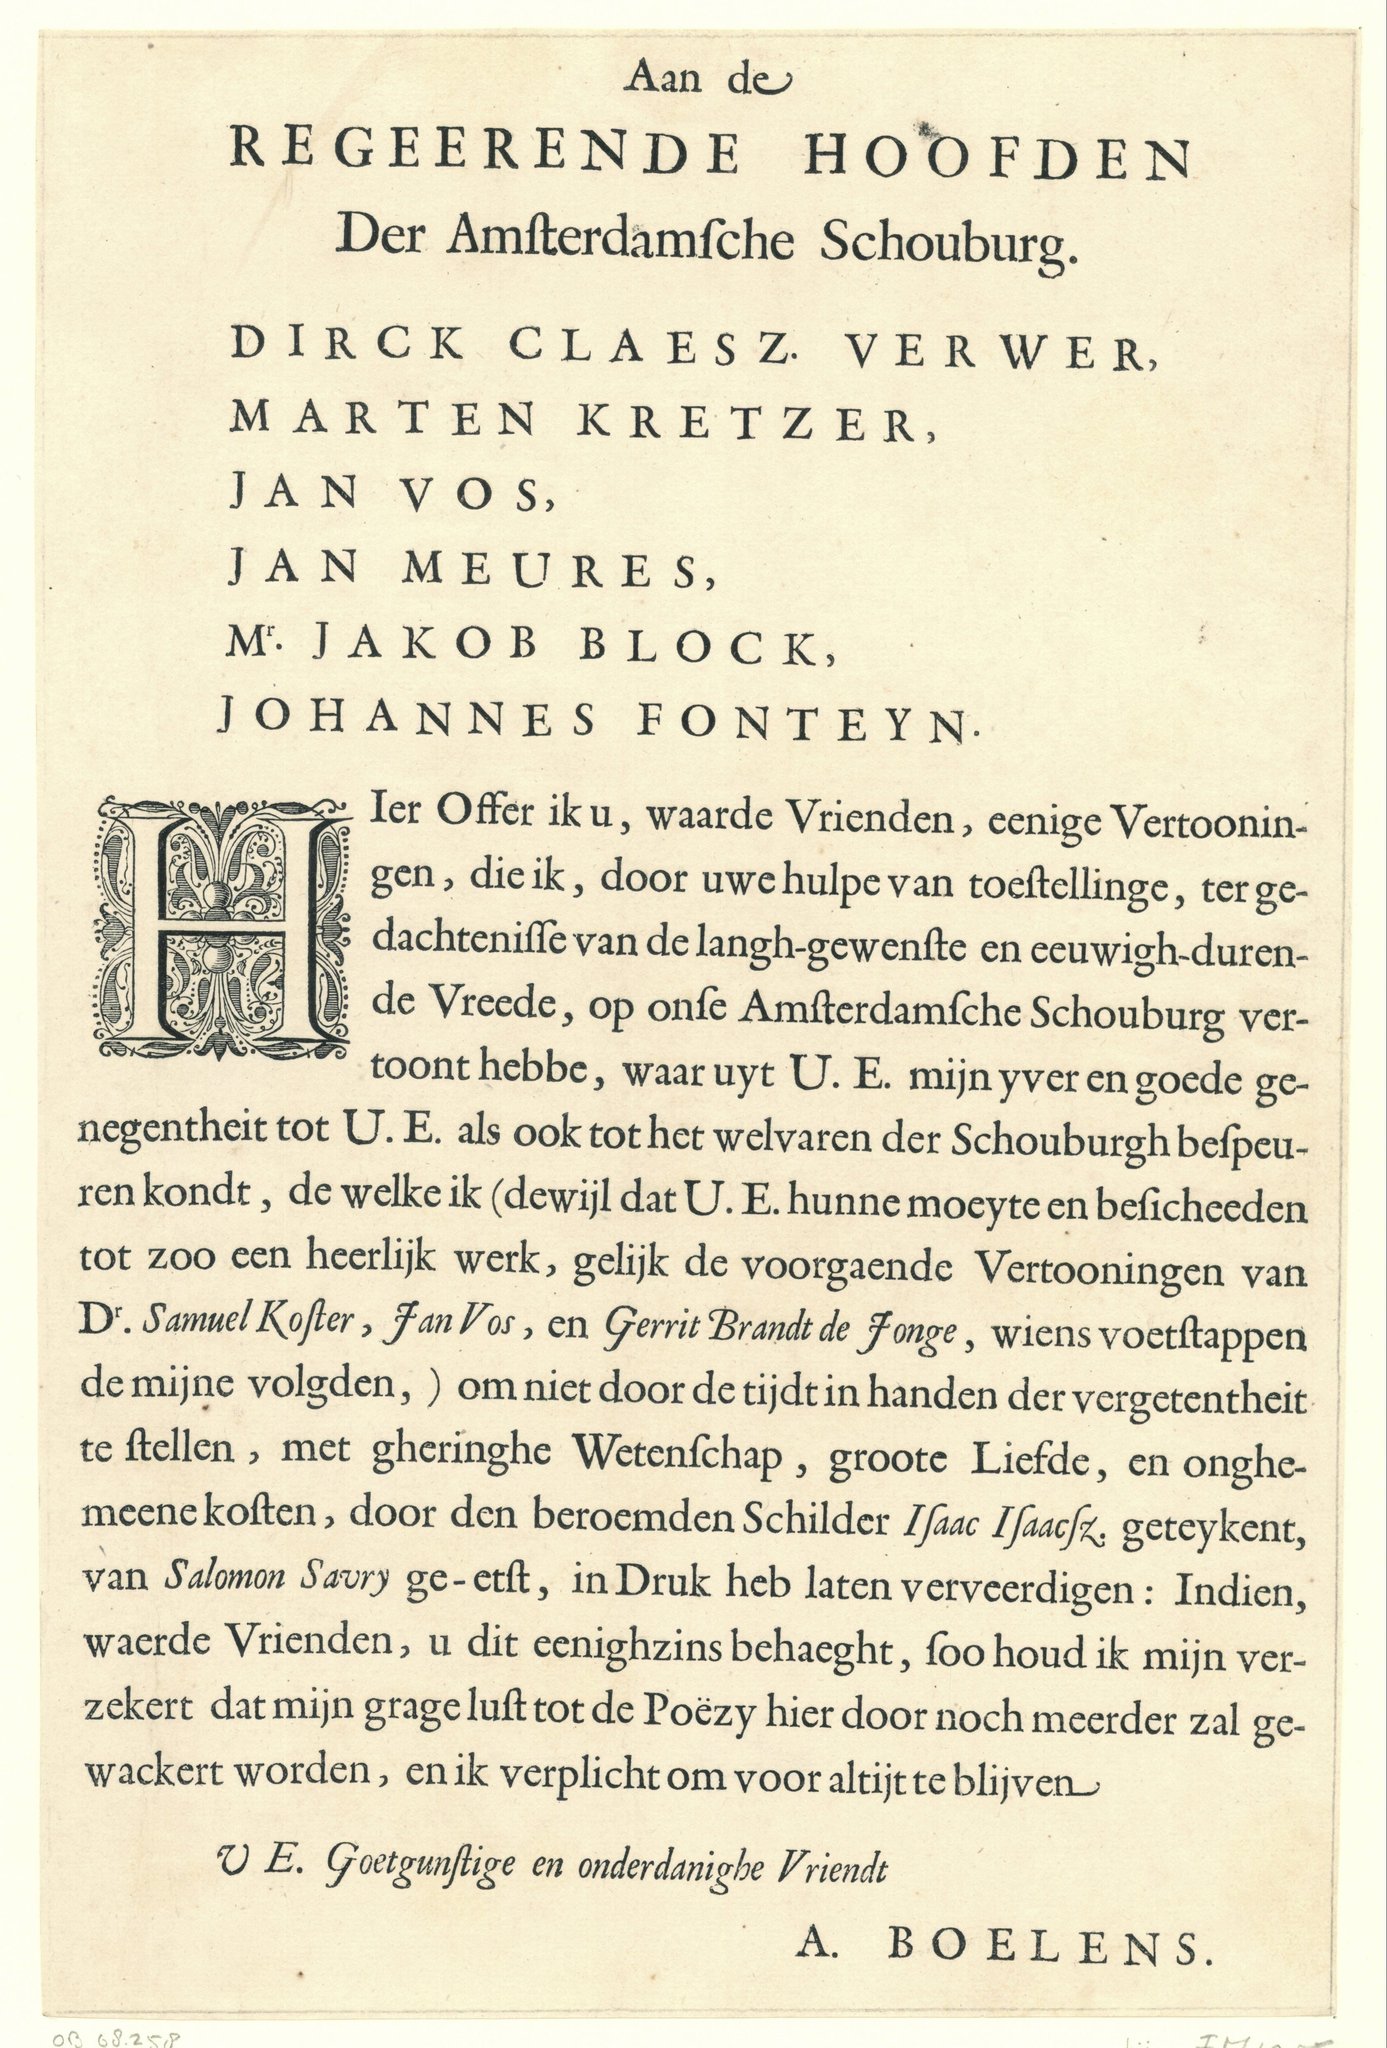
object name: print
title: De zes vertooningen die op de schouburg (...) vertoont zijn den 23 iunij 1648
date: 1649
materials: paper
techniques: letterpress printing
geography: amsterdam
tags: amsterdam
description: Blad met opdracht aan het bestuur van de Amsterdamse Schouwburg: Dirck Claesz. Verwer, Marten Kretzer, Jan Vos, Jan Meures, Mr. Jakob Block en Johannes Fonteyn. Tekstblad behorend bij de uitgave van zes prenten met voorstellingen van de vertoningen die opgevoerd zijn op de Schouwburg te Amsterdam op 23 juni 1648 naar aanleiding van het sluiten van de Vrede van Munster.